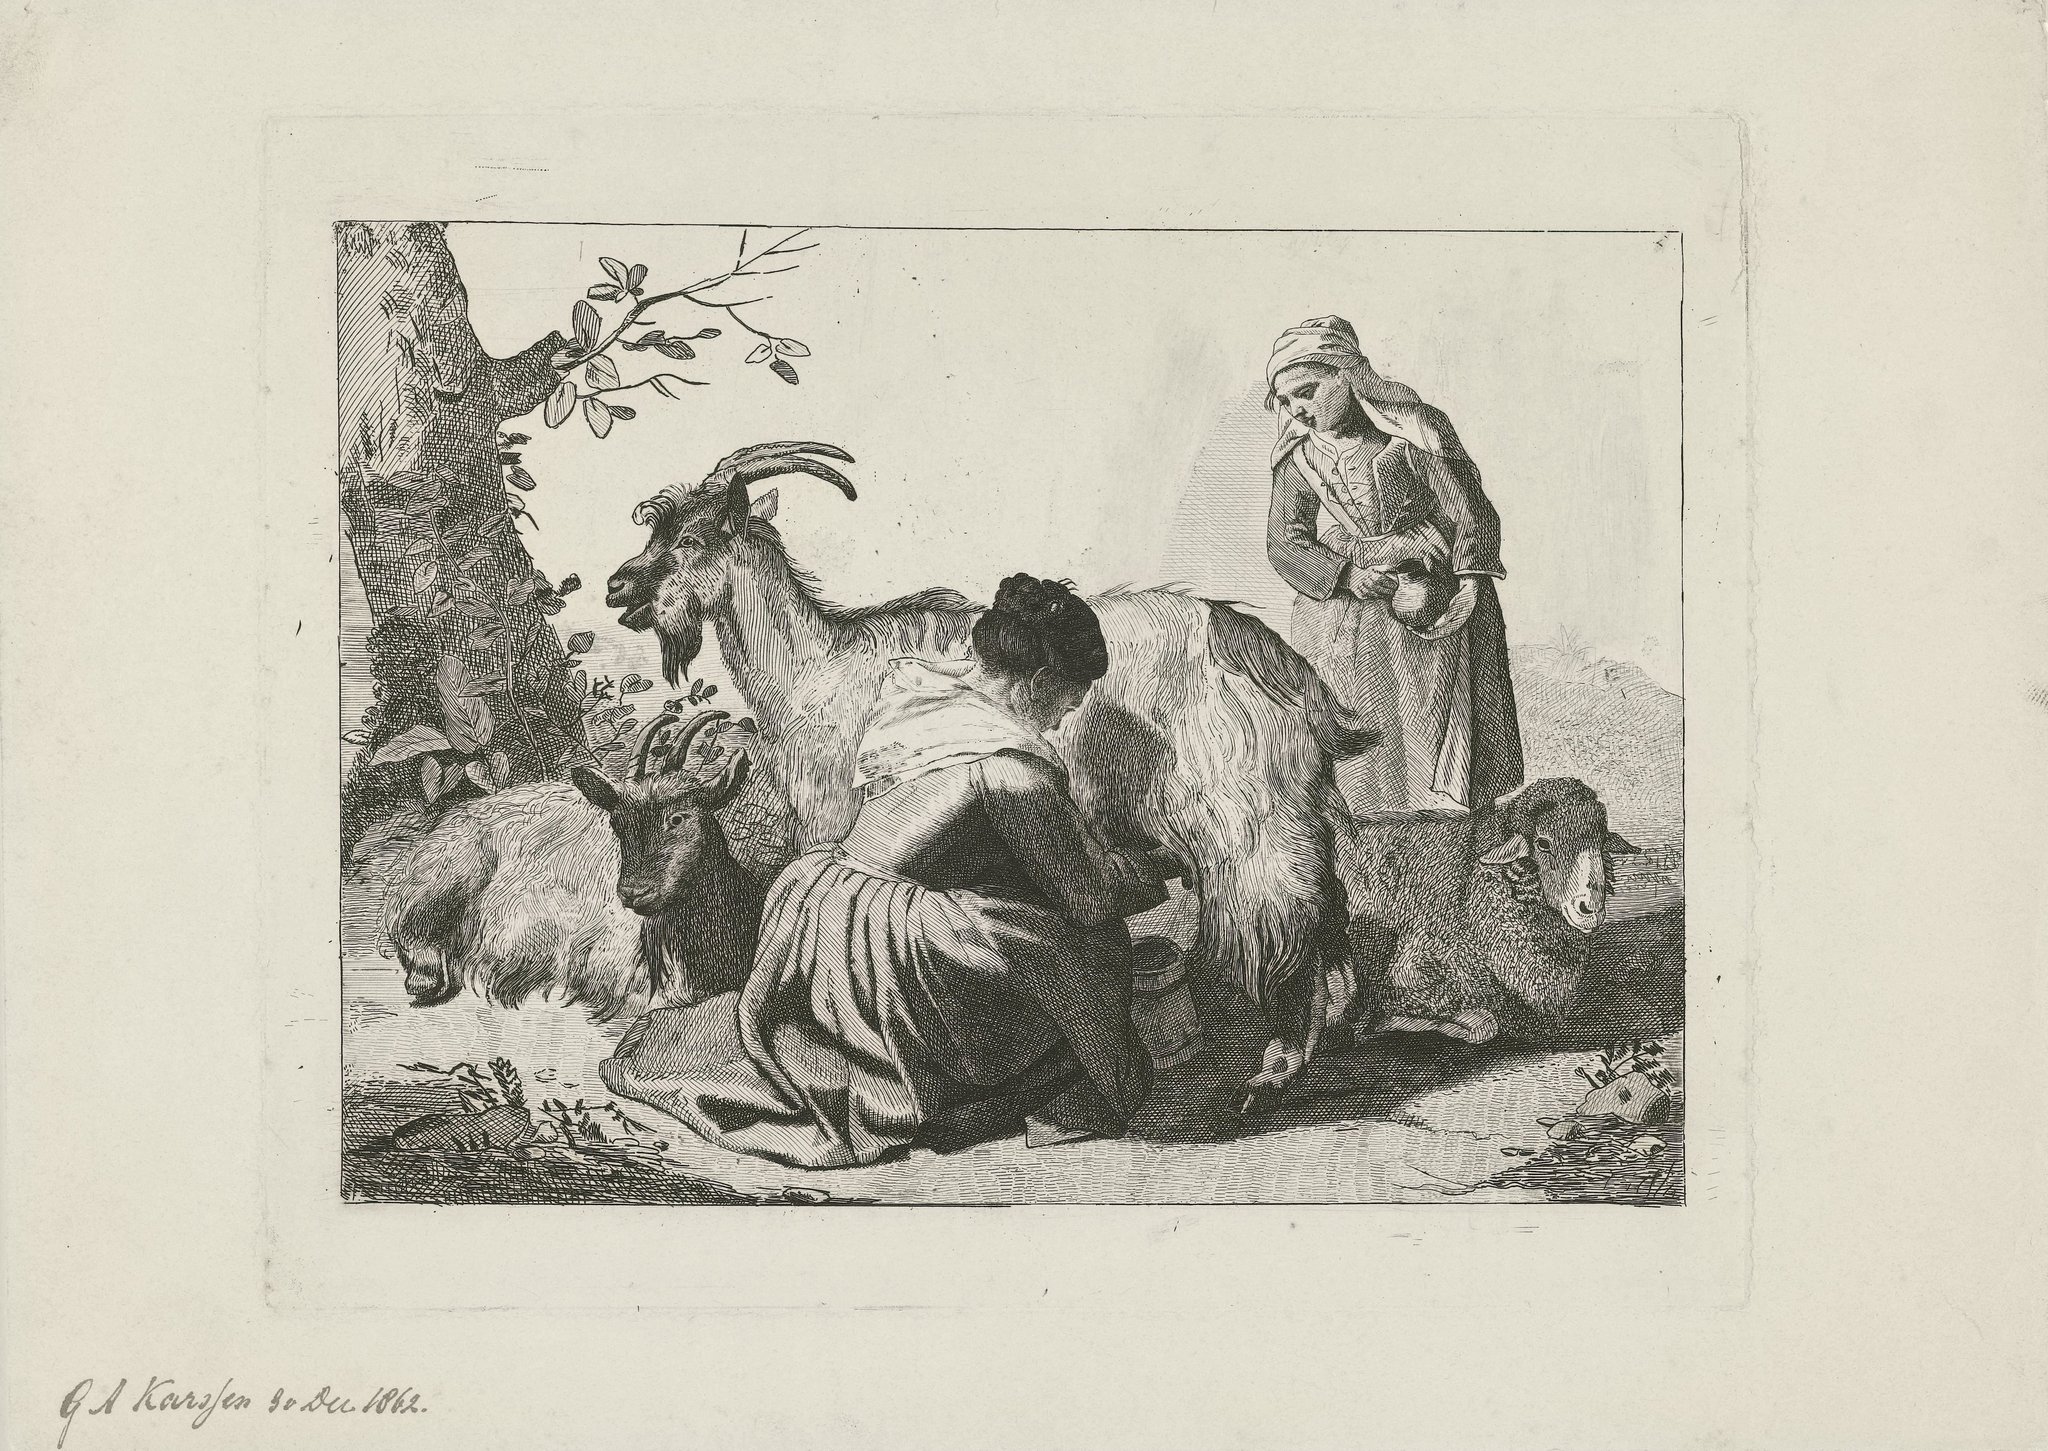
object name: print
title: Geiten melken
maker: george andries karsen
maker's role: print maker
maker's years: 1843-1912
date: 1862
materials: paper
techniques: etching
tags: sheep, goat, milkmaid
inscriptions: inscription: ‘GA Karsen 30 dec 1862’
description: Landschap met schapen en geiten waarin een geit gemolken wordt.